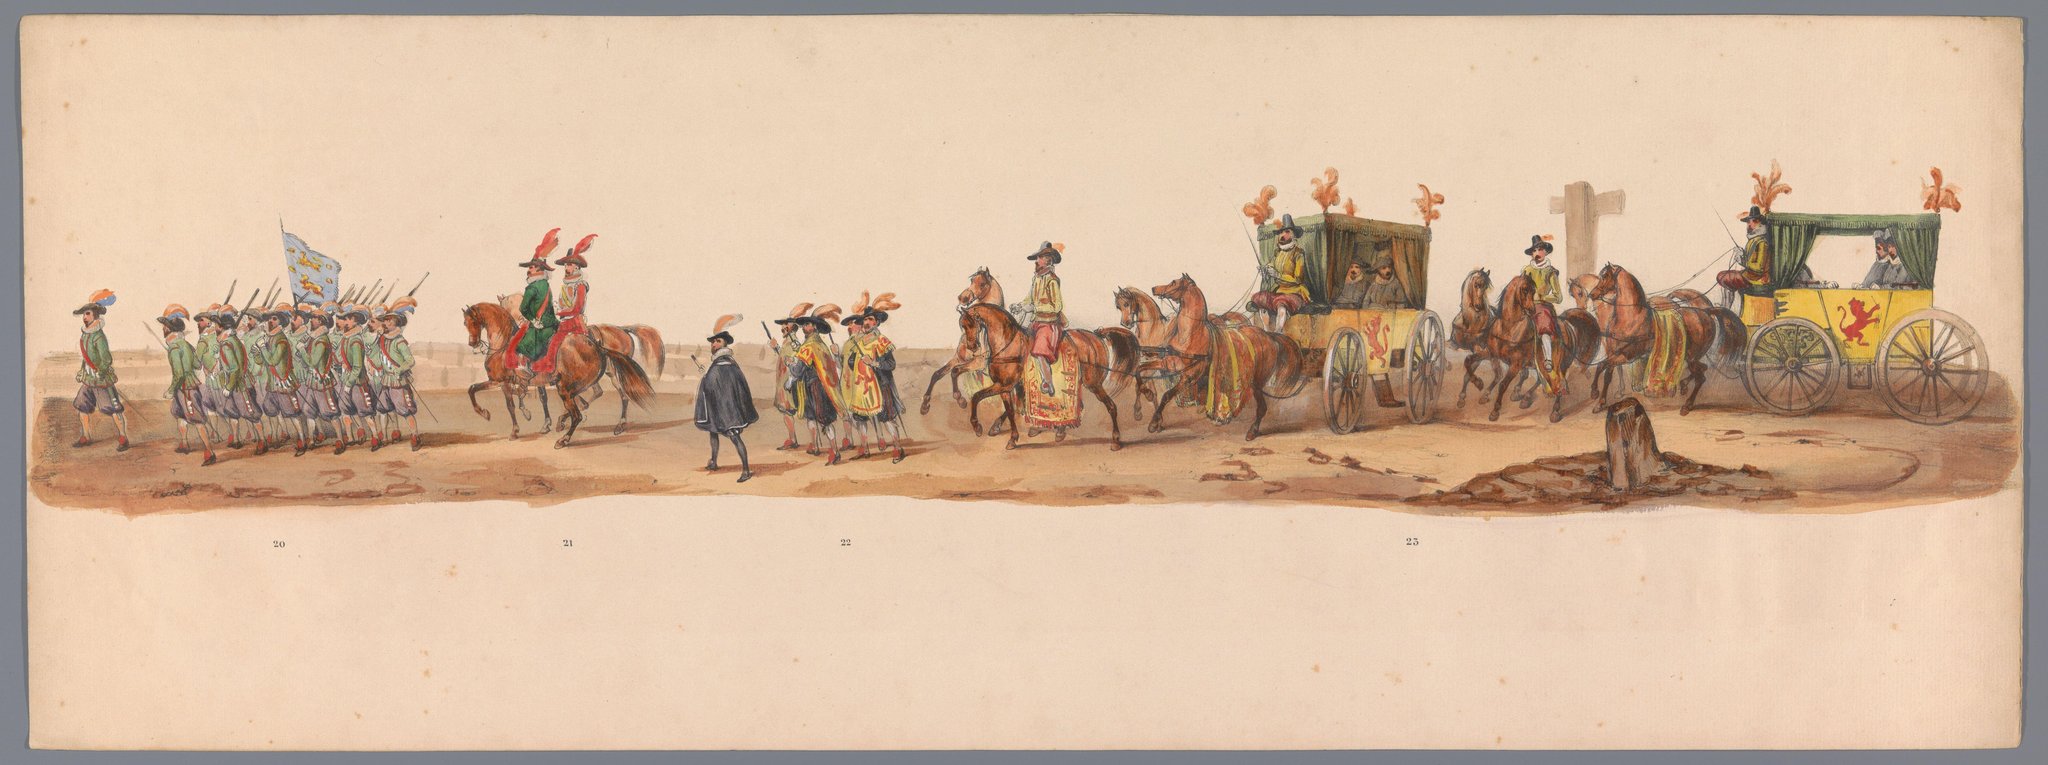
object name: print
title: Historische optocht bij het tweede eeuwfeest van de Utrechtse Hogeschool, 1836 (plaat 6)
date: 1837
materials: paper, watercolor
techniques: hand coloring, lithograph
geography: paris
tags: students' pageant, costumes used in pageants, battle of nieuwpoort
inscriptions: date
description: Historische gekostumeerde optocht van de studenten van de Hogeschool van Utrecht op 16 juni 1836, bij de viering van het tweede eeuwfeest van de Utrechtse Hogeschool. De optocht verbeeldt de intocht van het Staatse leger in Oostende op 3 juli 1600, daags na de overwinning in de Slag bij Nieuwpoort. Zesde plaat in een serie van tien ongenummerde platen, met de groepen genummerd 20-23.